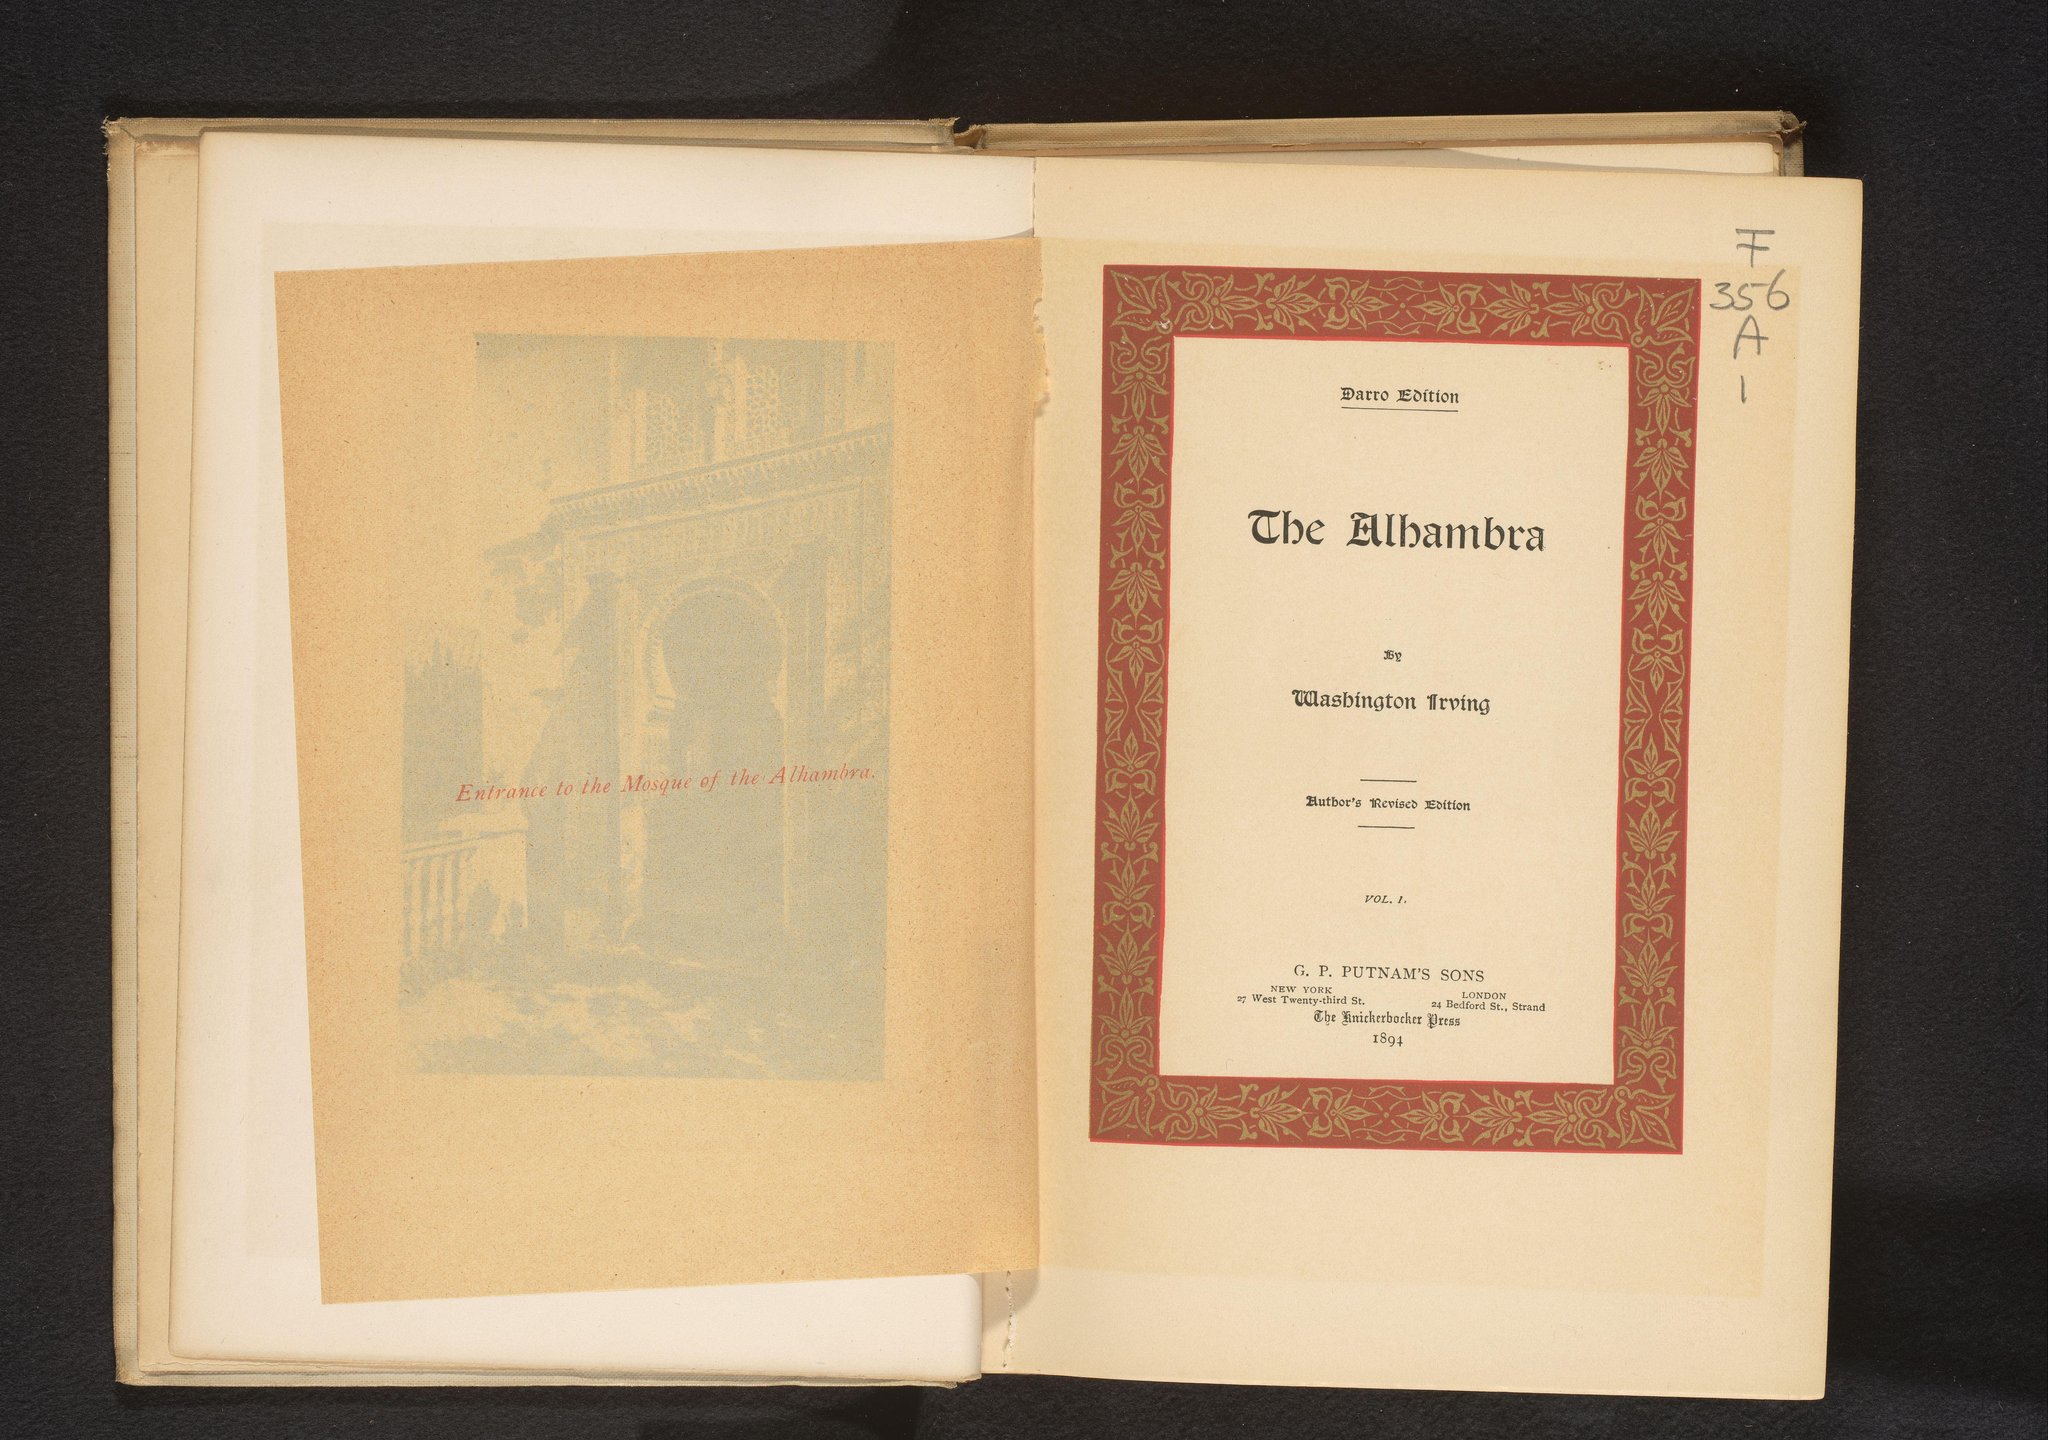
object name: book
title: The Alhambra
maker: washington irving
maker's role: schrijver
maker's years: 1783-1859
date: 1894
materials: paper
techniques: photoaquatint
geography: new york city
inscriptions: inscription: ‘Compliments of your friends june 26-1900 A.L. G.B. A.B. S.R. A.R.’